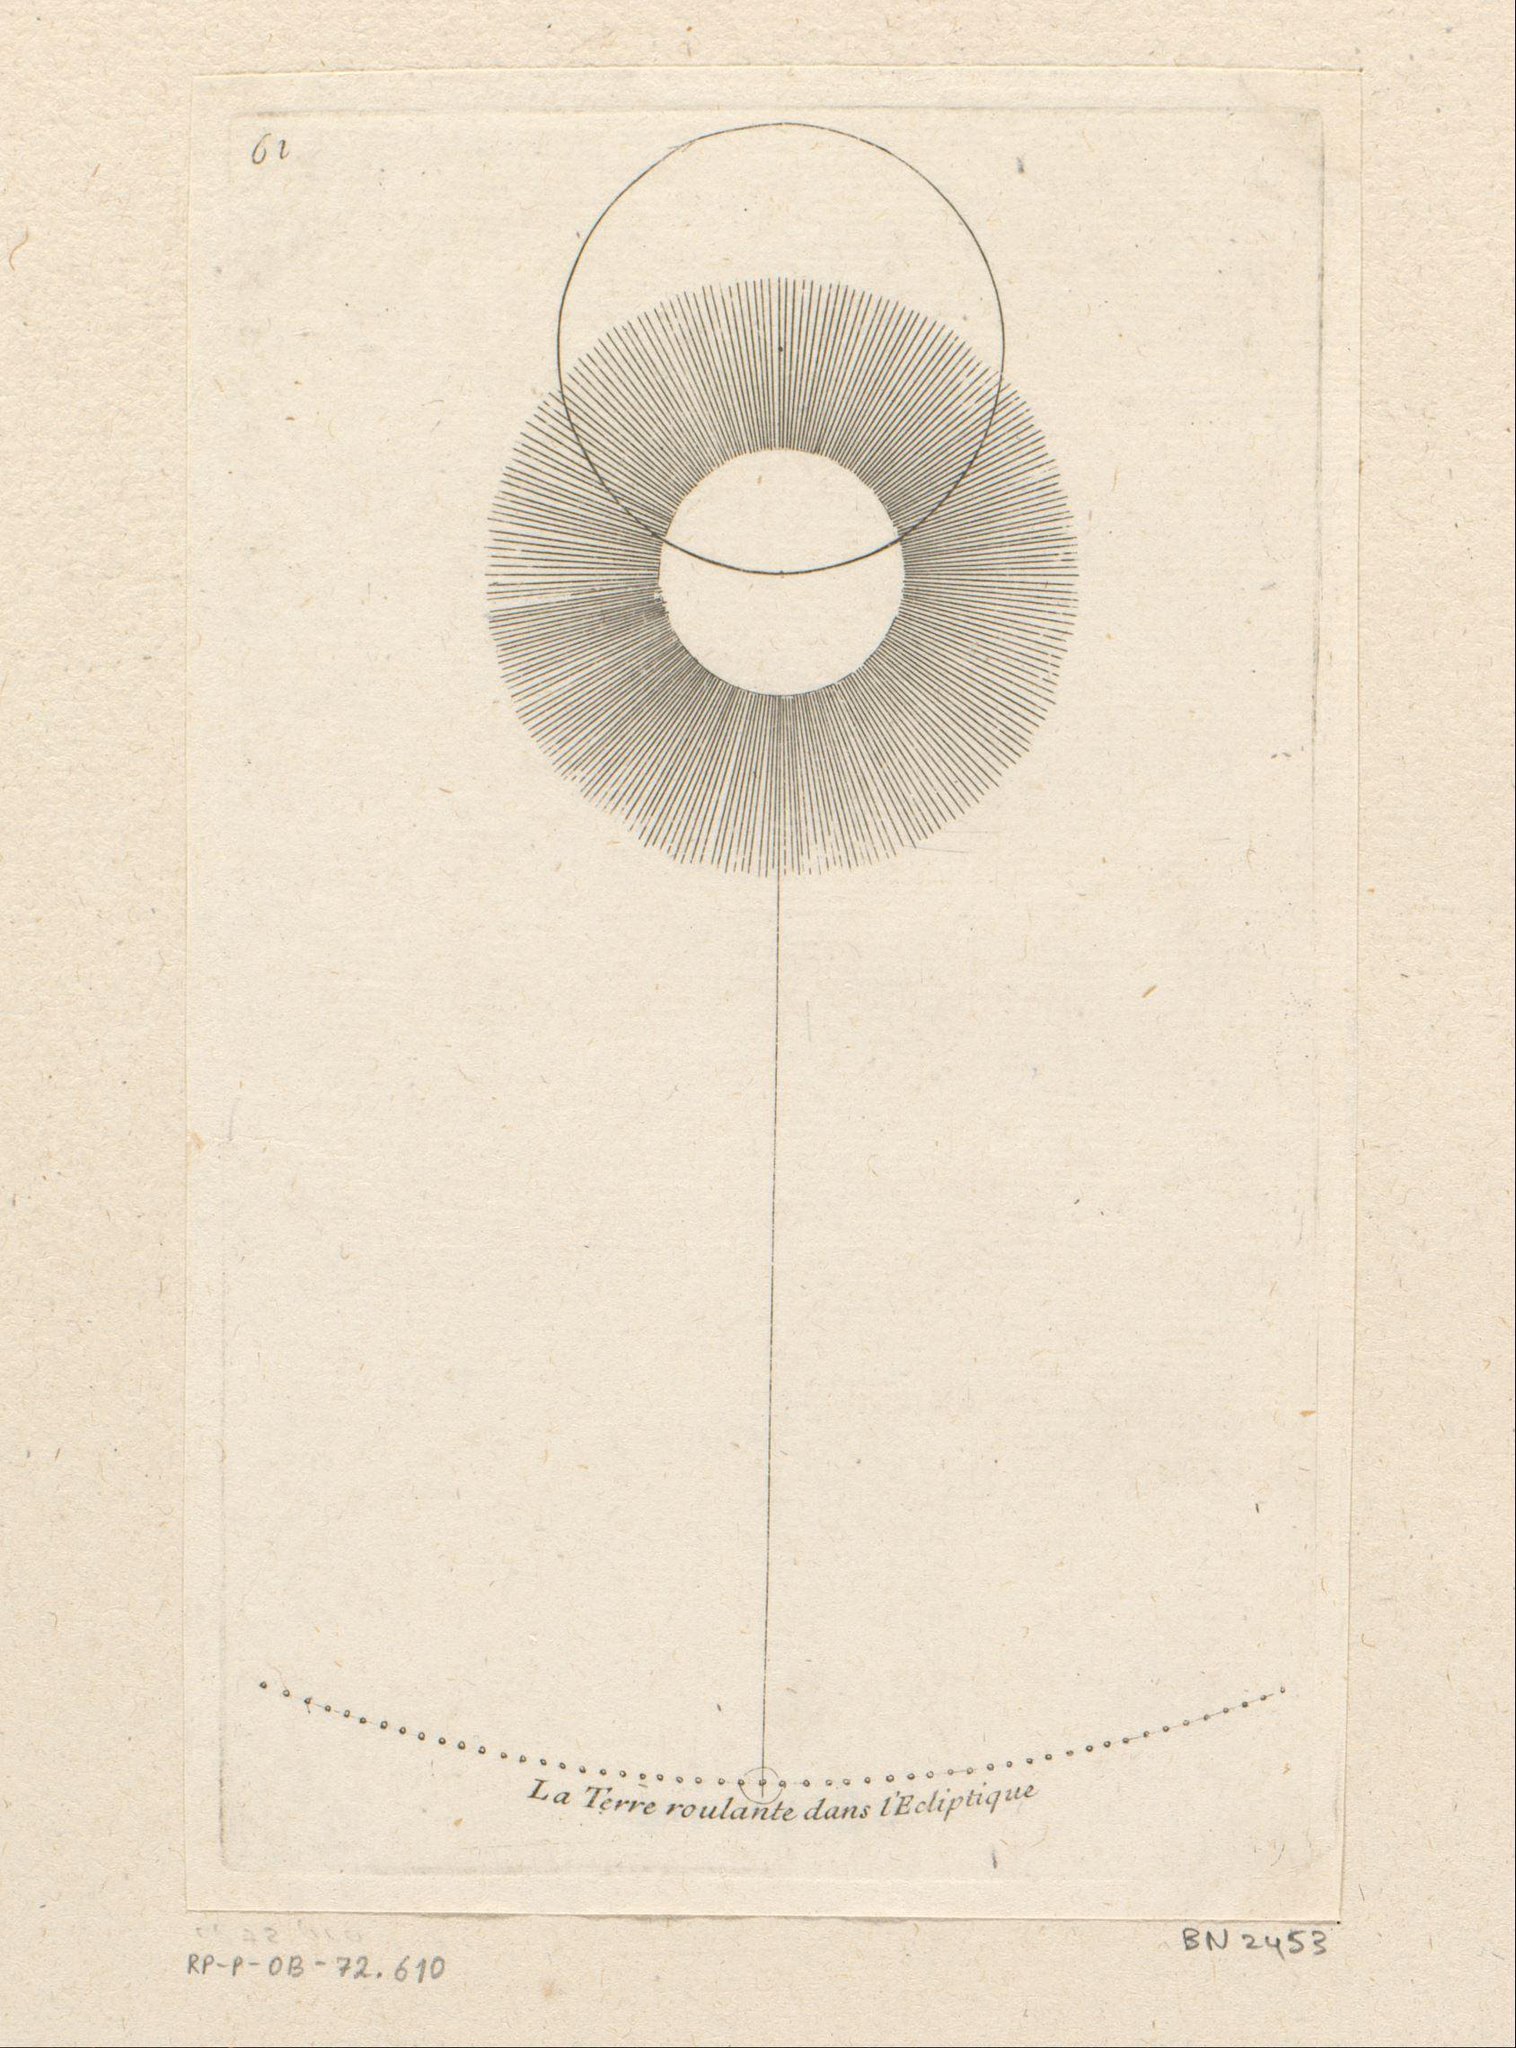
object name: book illustration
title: Zon die rond het centrum van de wereld draait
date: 1706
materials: paper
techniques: etching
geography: france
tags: sun as celestial body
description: Prent uit: Leclerc, Sébastien. Nouveau systeme du monde conforme à l'Ecriture sainte. Où les phénomènes sont expliquez sans excentricité de mouvement (...). Paris: Pierre Giffart, 1706.